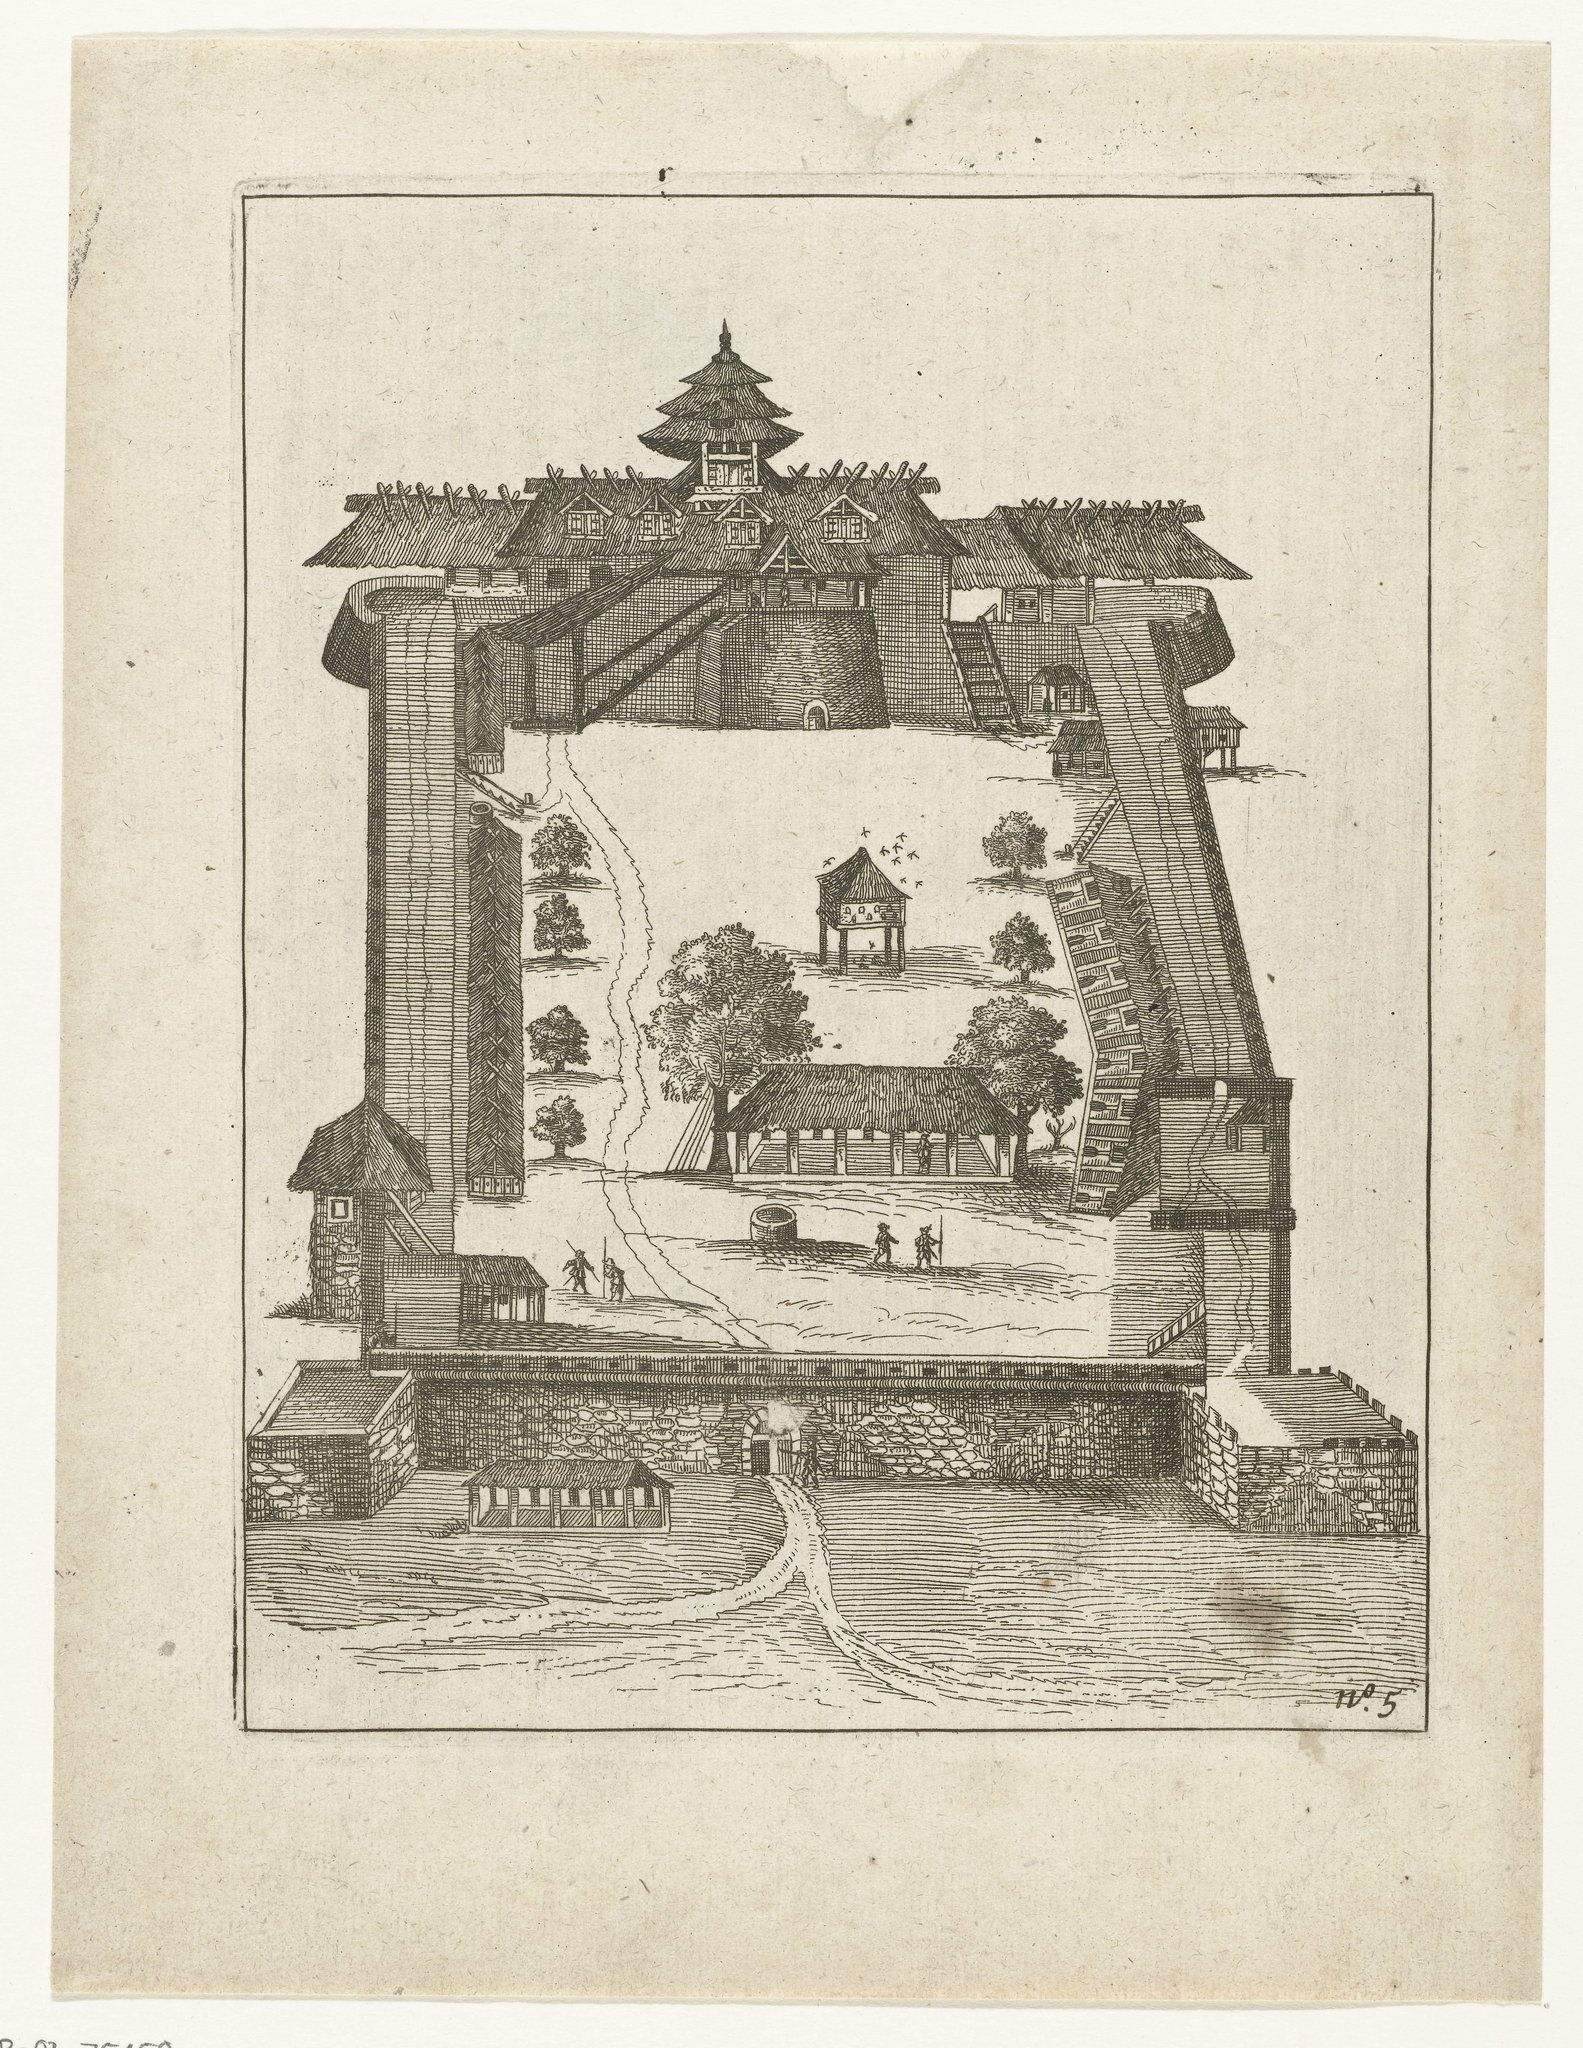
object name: print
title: Het fort op Ambon, 1607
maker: Anonymous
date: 1644-1646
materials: paper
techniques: etching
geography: northern netherlands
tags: rotterdam, mayor, landscapes in tropical and sub-tropical regions, exploration, expedition, voyage of discovery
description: Gebruikt als illustratie: Historisch Verhael Vande treffelijcke Reyse, gedaen naer de Oost-Indien ende China, met elf Schepen. Door den Manhaften Admirael Cornelis Matelief de Jonge. Inden Jaren 1605. 1606. 1607. ende 1608. Deze tekst opgenomen in : I. Commelin, Begin ende voortgangh, van de Vereenighde Nederlantsche Geoctroyeerde Oost-Indische Compagnie, J. Janssonius, Amsterdam 1646. Genummerd: No. 5.